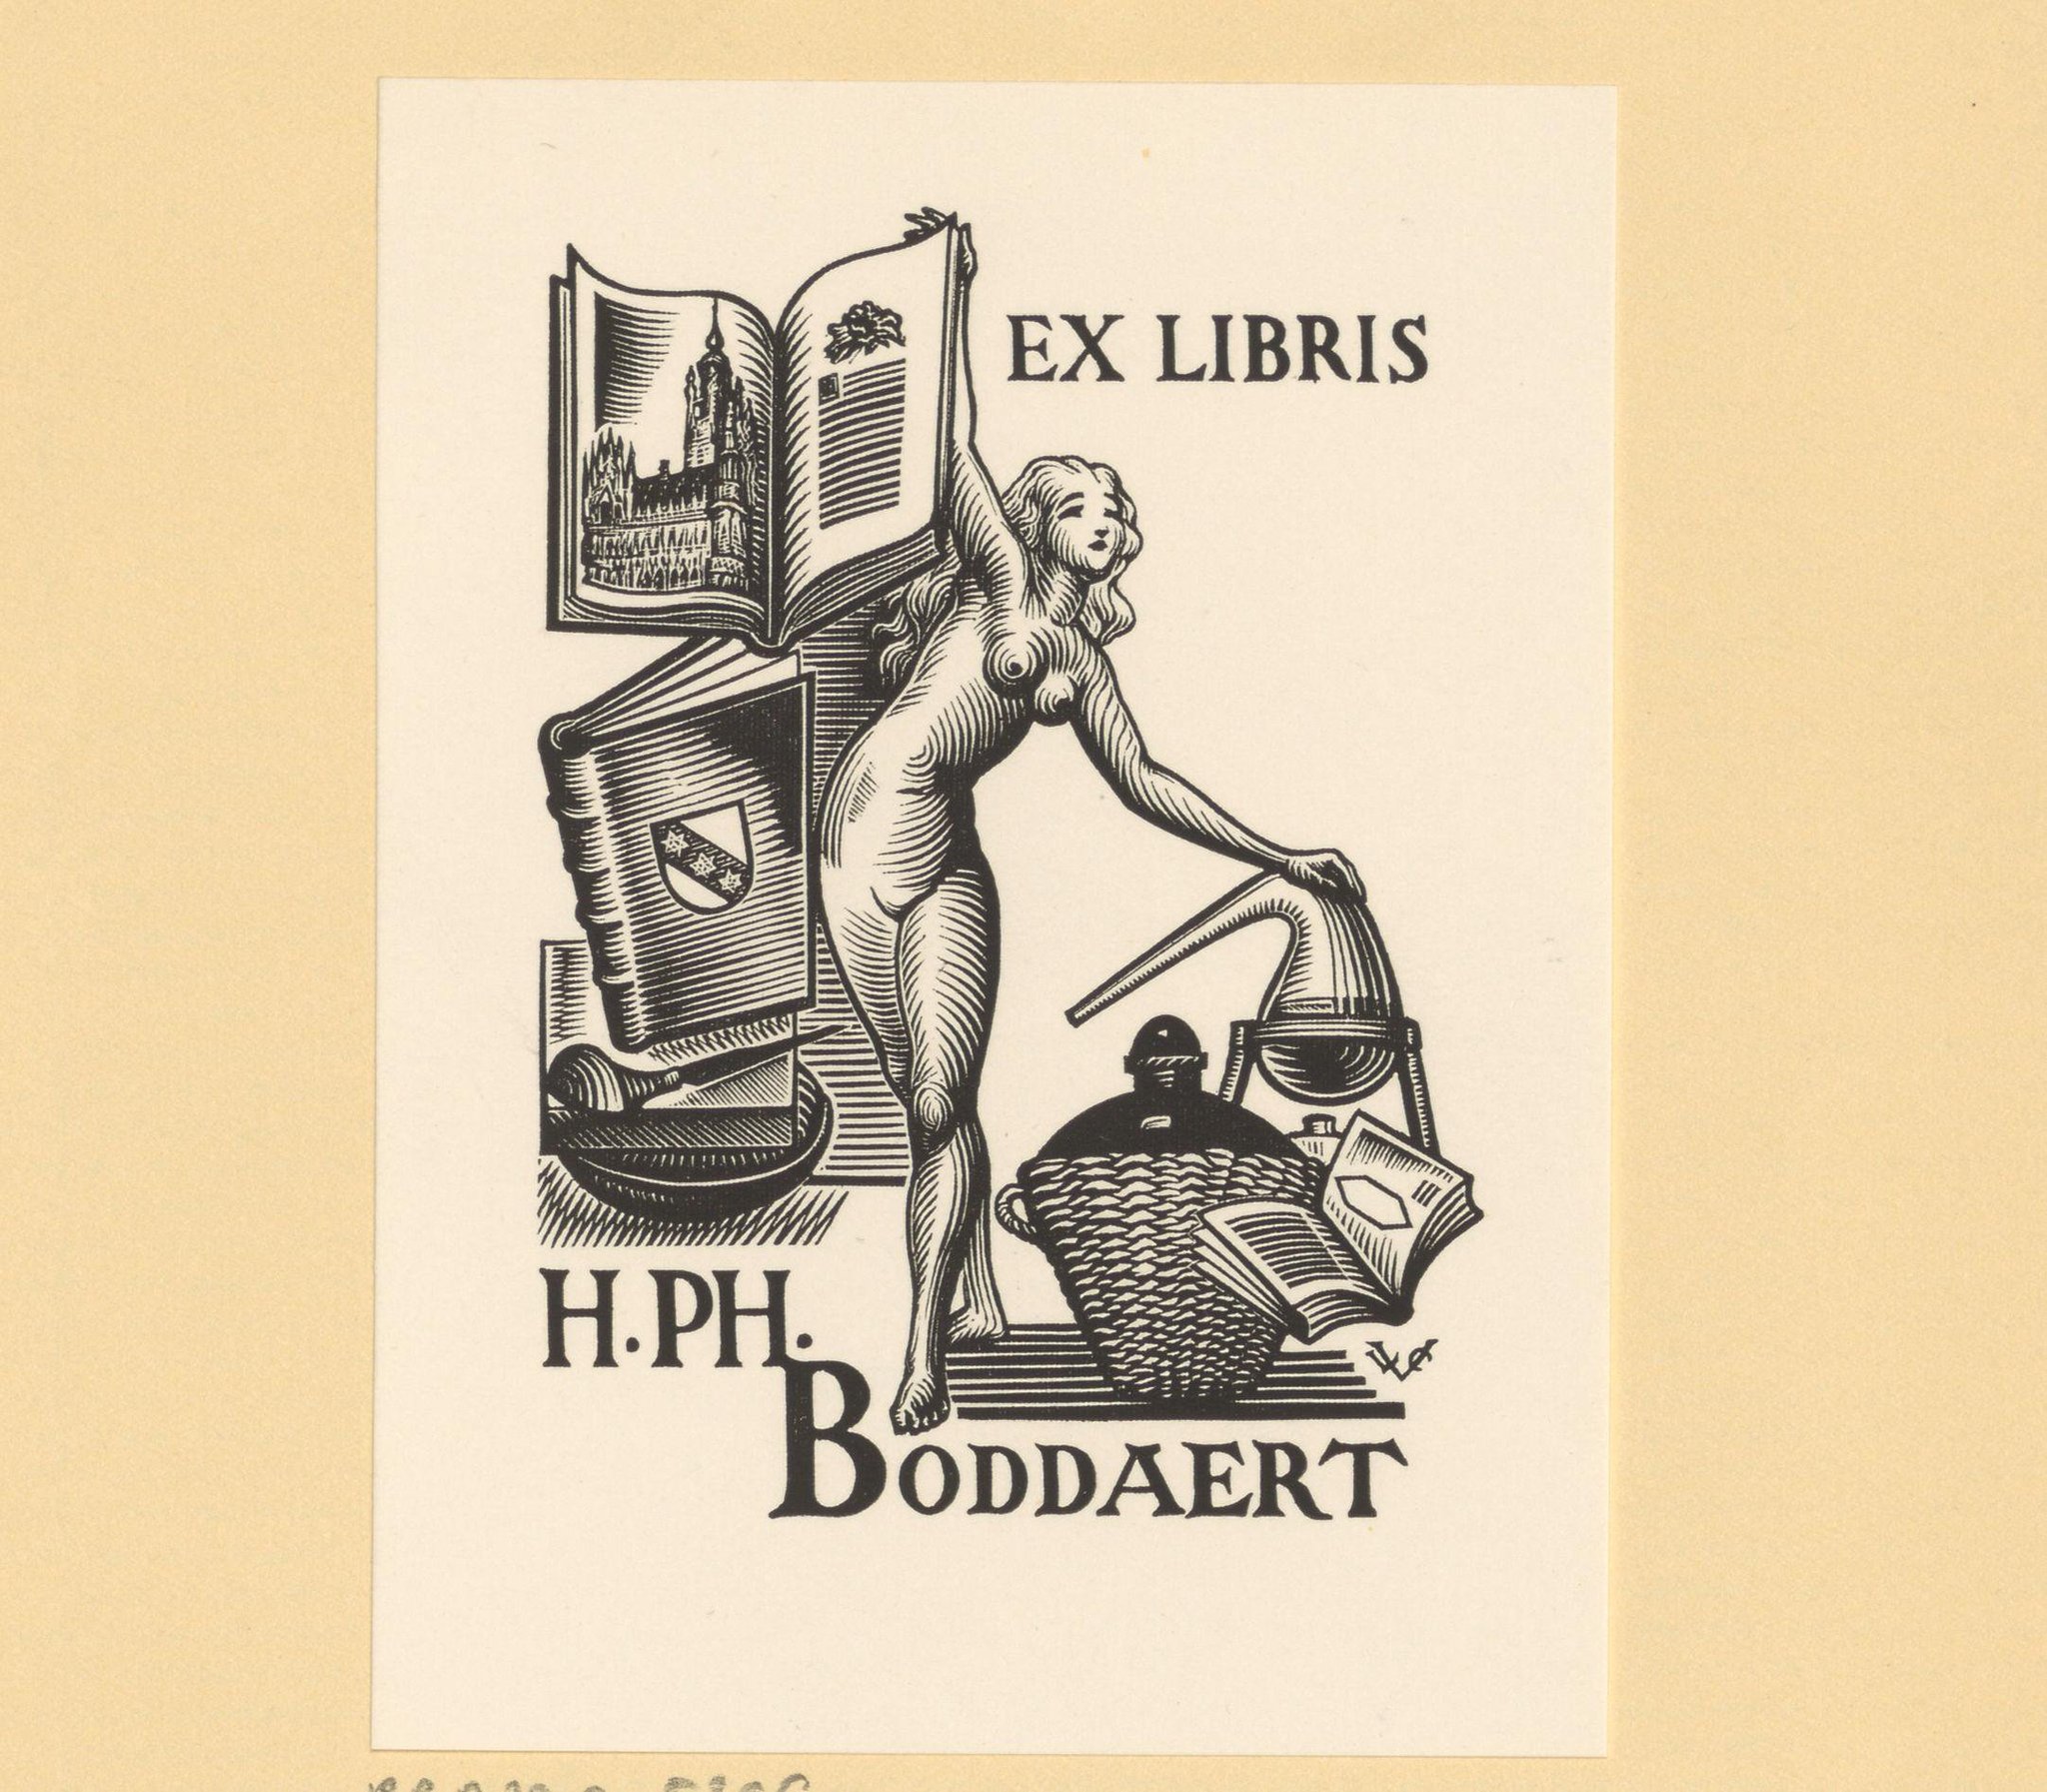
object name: bookplate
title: Ex libris van H.Ph. Boddaert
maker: valentin le campion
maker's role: print maker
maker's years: 1861-1952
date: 1934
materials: paper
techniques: engraving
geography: france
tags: additional stages: distillation (destillatio), tools, implements of graphic artist (burin), woman (showing herself) undressed, quasi-nude, book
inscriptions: inscription: ‘287d’, workshop stamp: ‘Valentin le Campion’